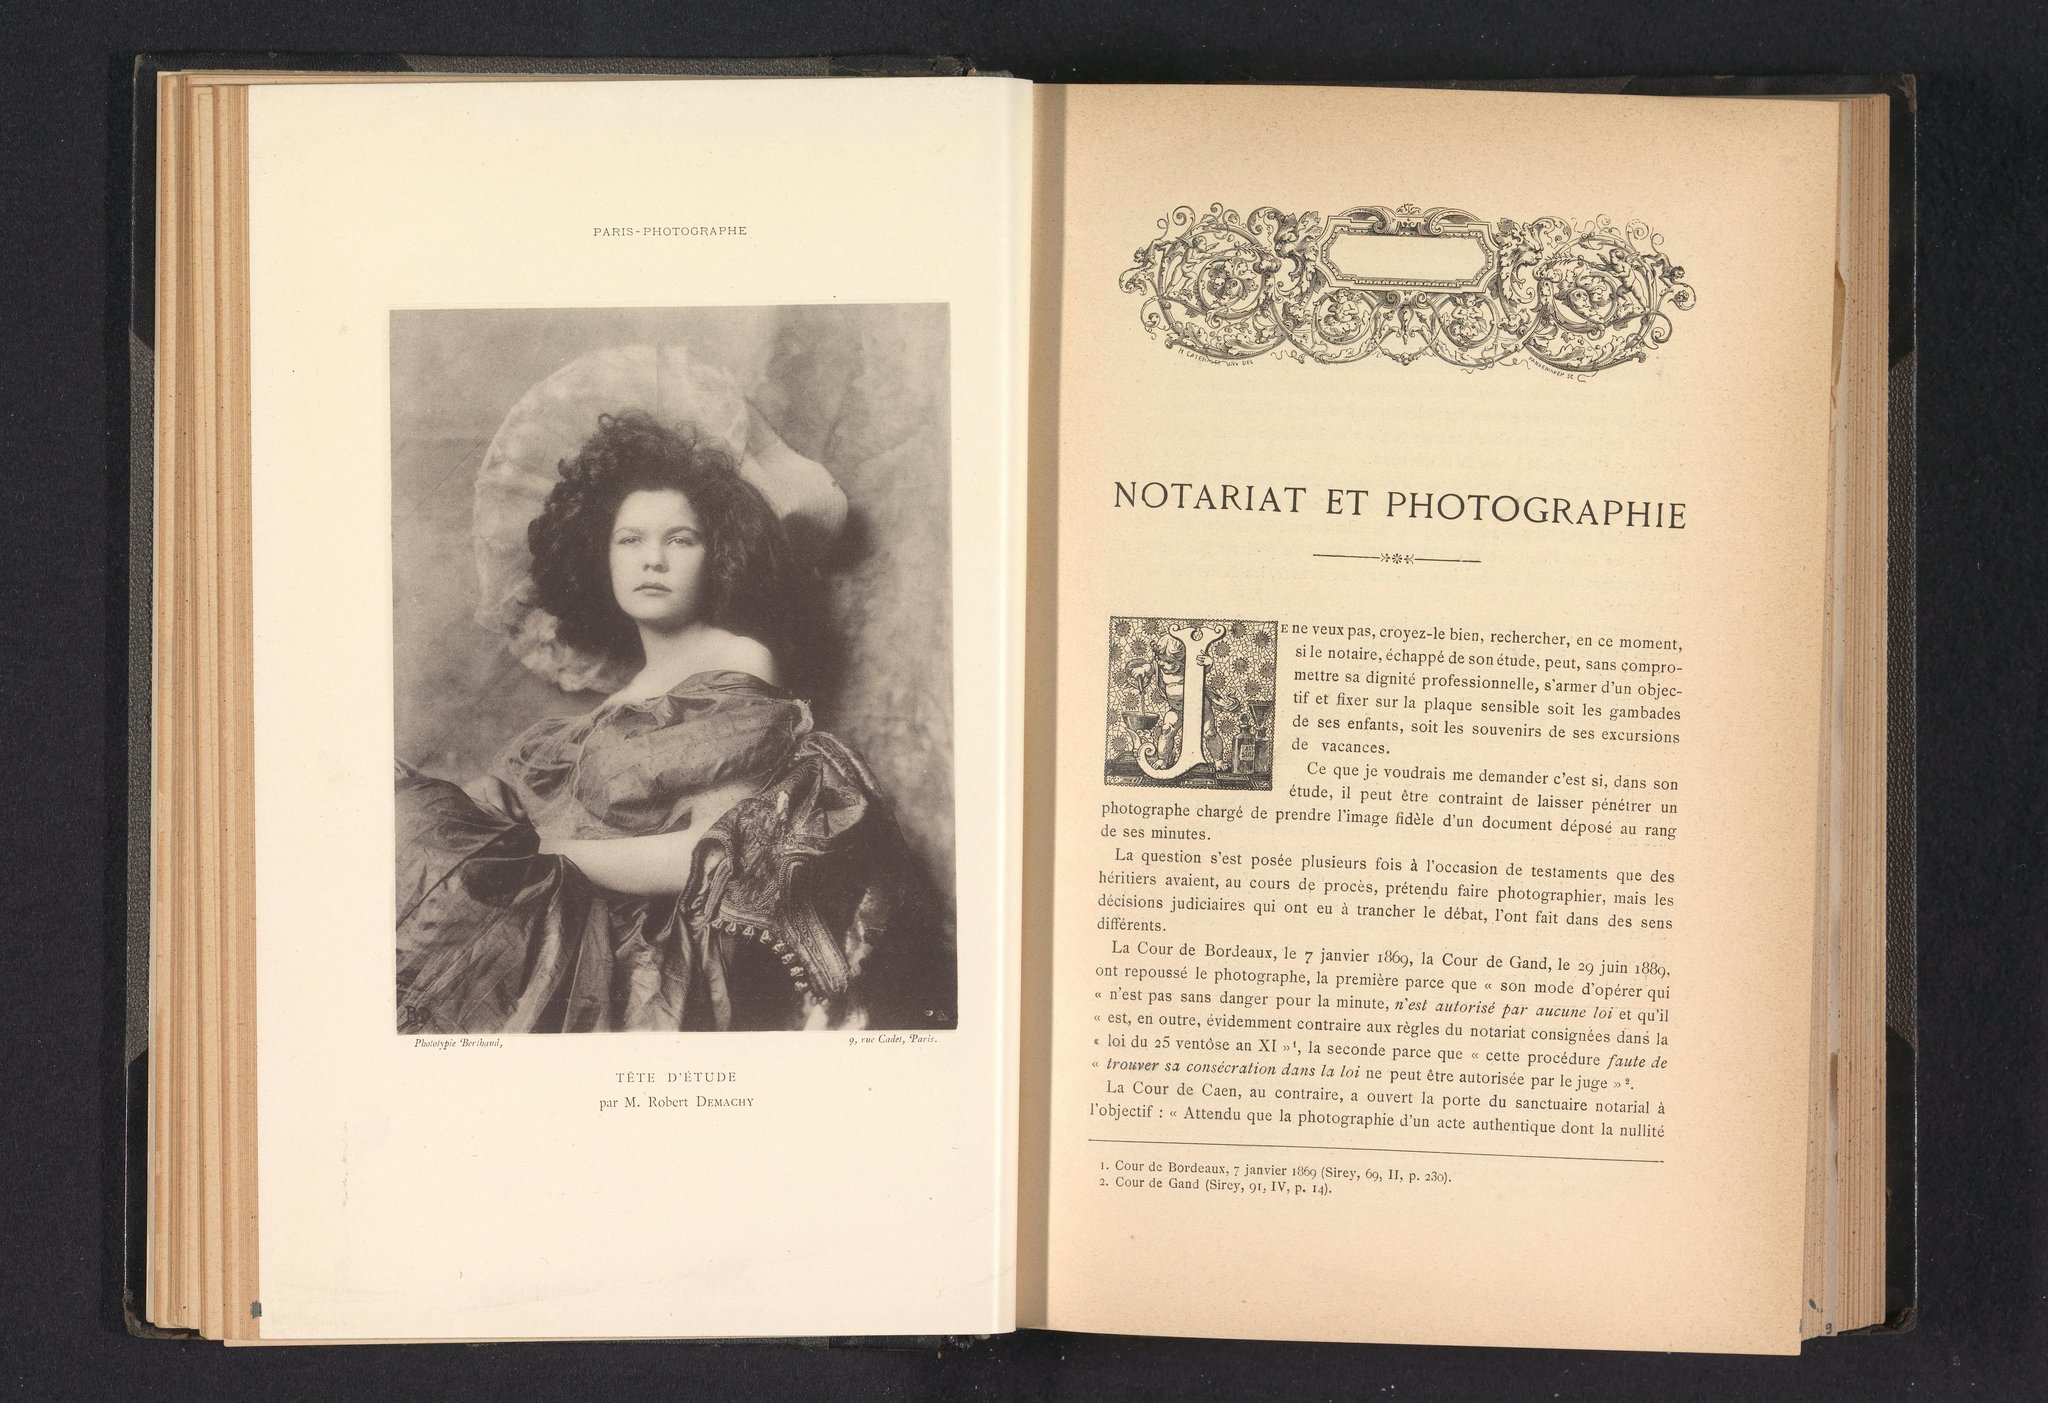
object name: page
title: Portret van een onbekende vrouw met een hoed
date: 1884-1894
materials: paper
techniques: photograph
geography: paris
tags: adult woman